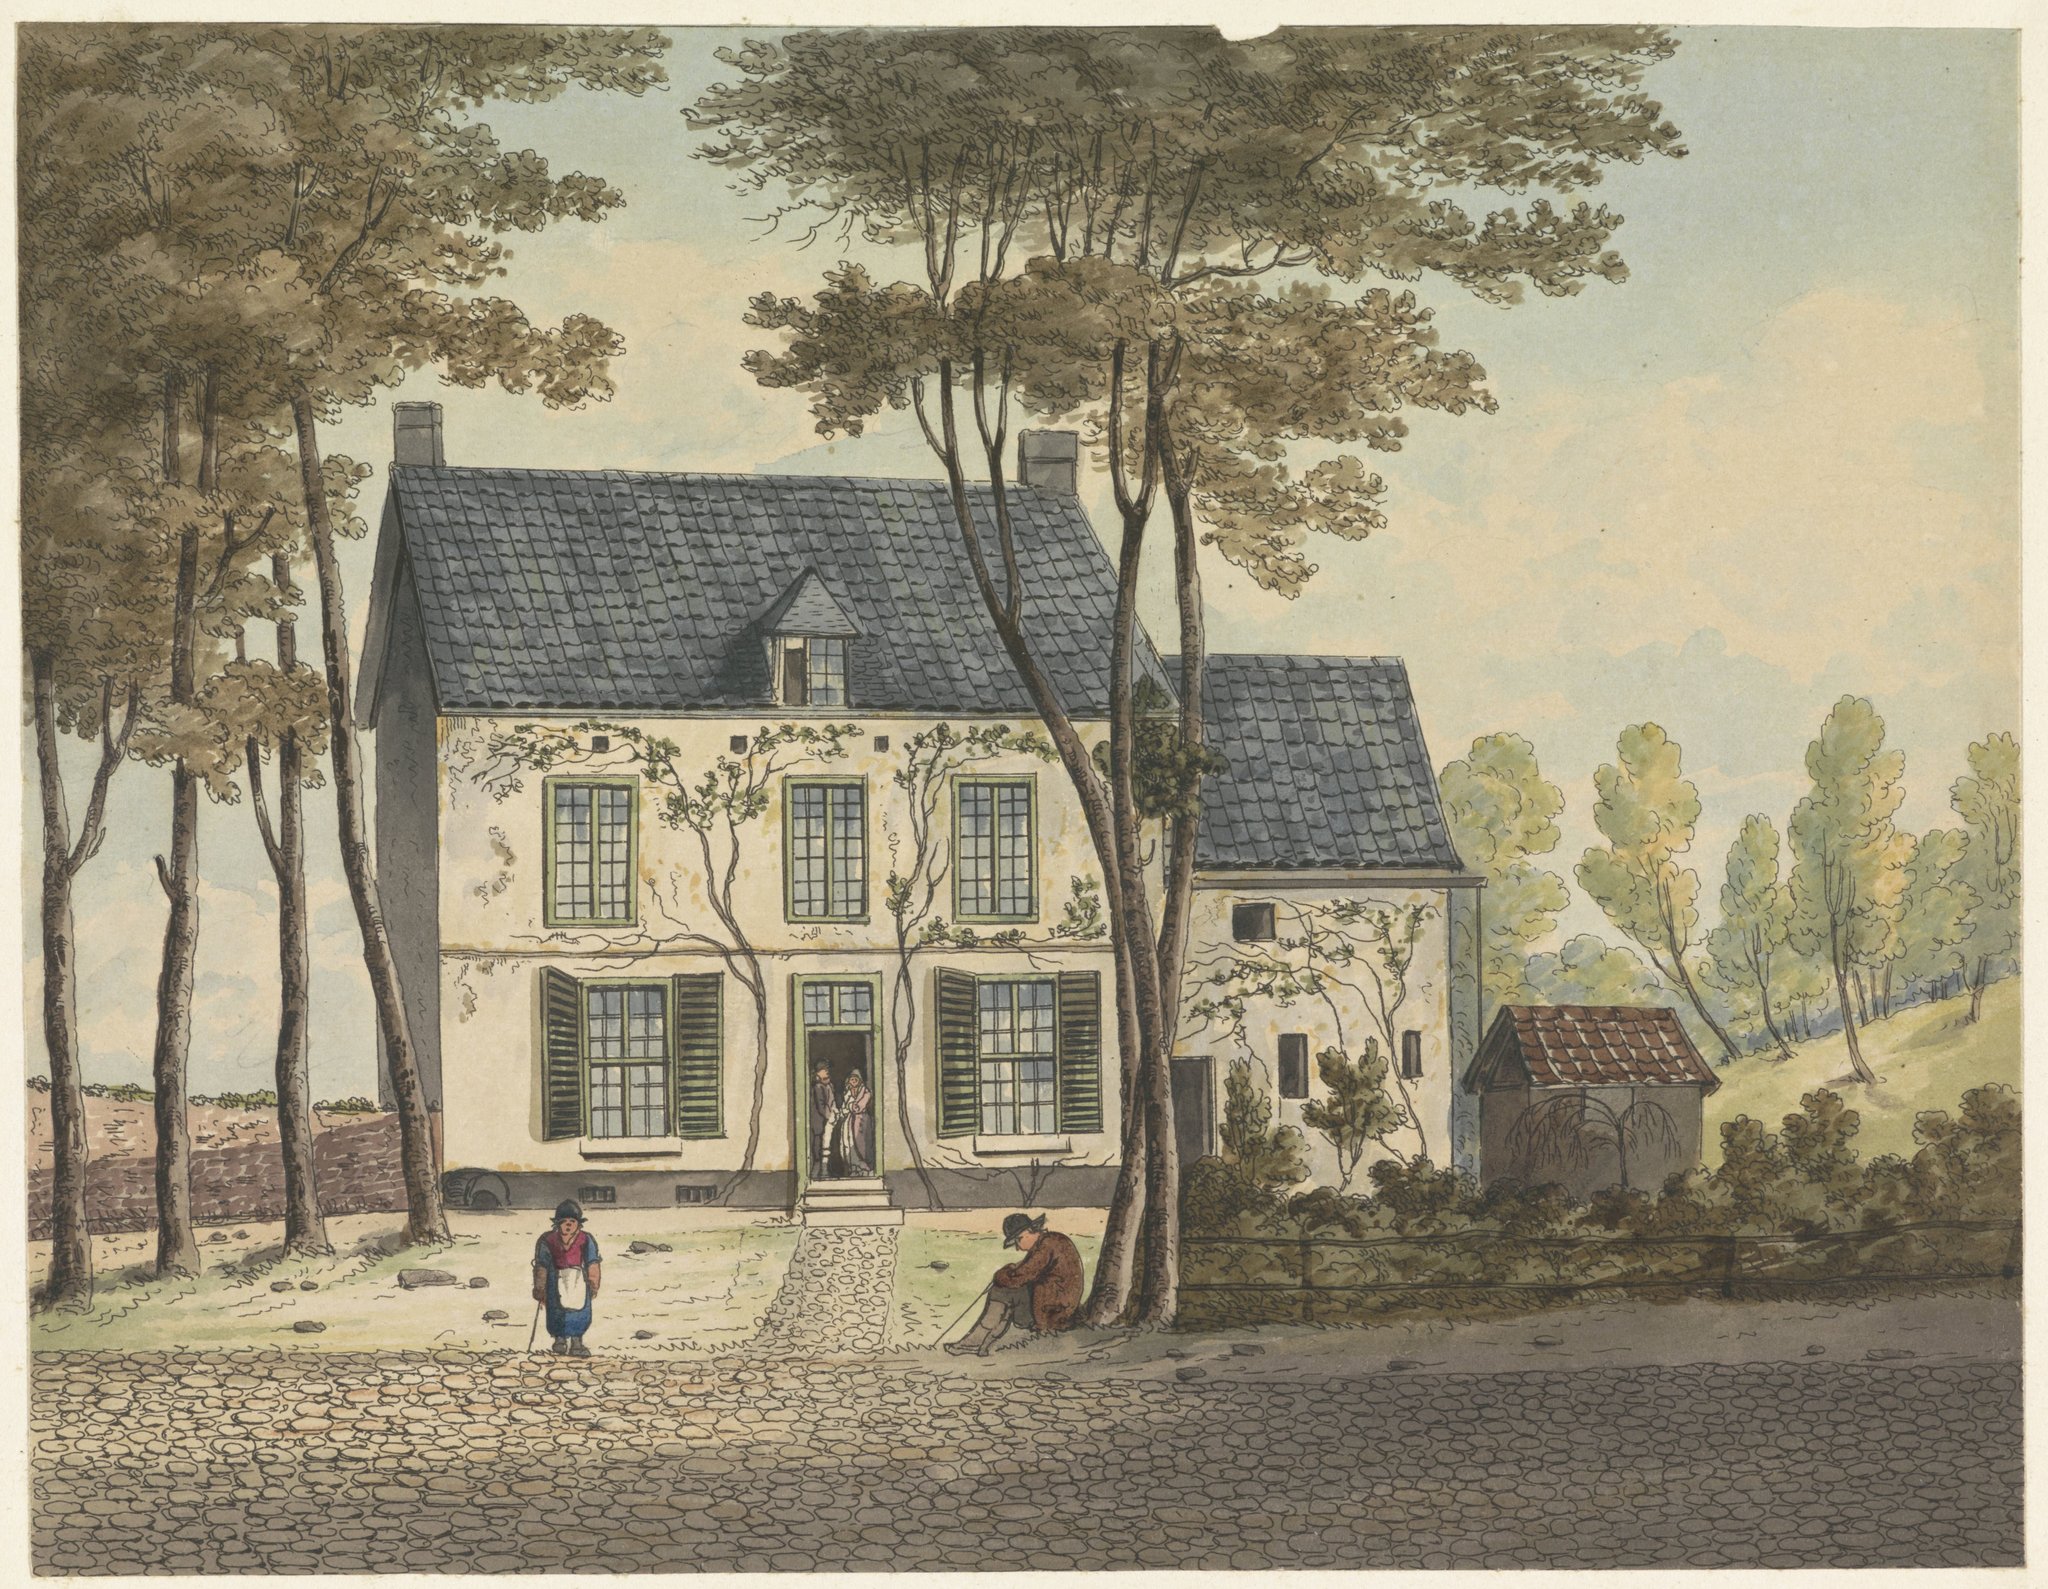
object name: print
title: Hoofdkwartier van Wellington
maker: Anonymous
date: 1815-1825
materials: paper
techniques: etching, hand coloring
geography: low countries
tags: walmer castle, arthur wellesley of wellington, waterloo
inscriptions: collector's mark: Lugt 2228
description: Gebouw in Waterloo waarin de hertog van Wellington tijdens de slag verbleef. Na de slag werden hier aandenkens aan de slag tentoongesteld. De gevel van het huis bedekt met (geschilderde?) klimop. Onderdeel van een serie van zeven platen met gezichten uit ca. 1820 van de omgeving waar de slag bij Waterloo plaatsvond op 18 juni 1815.